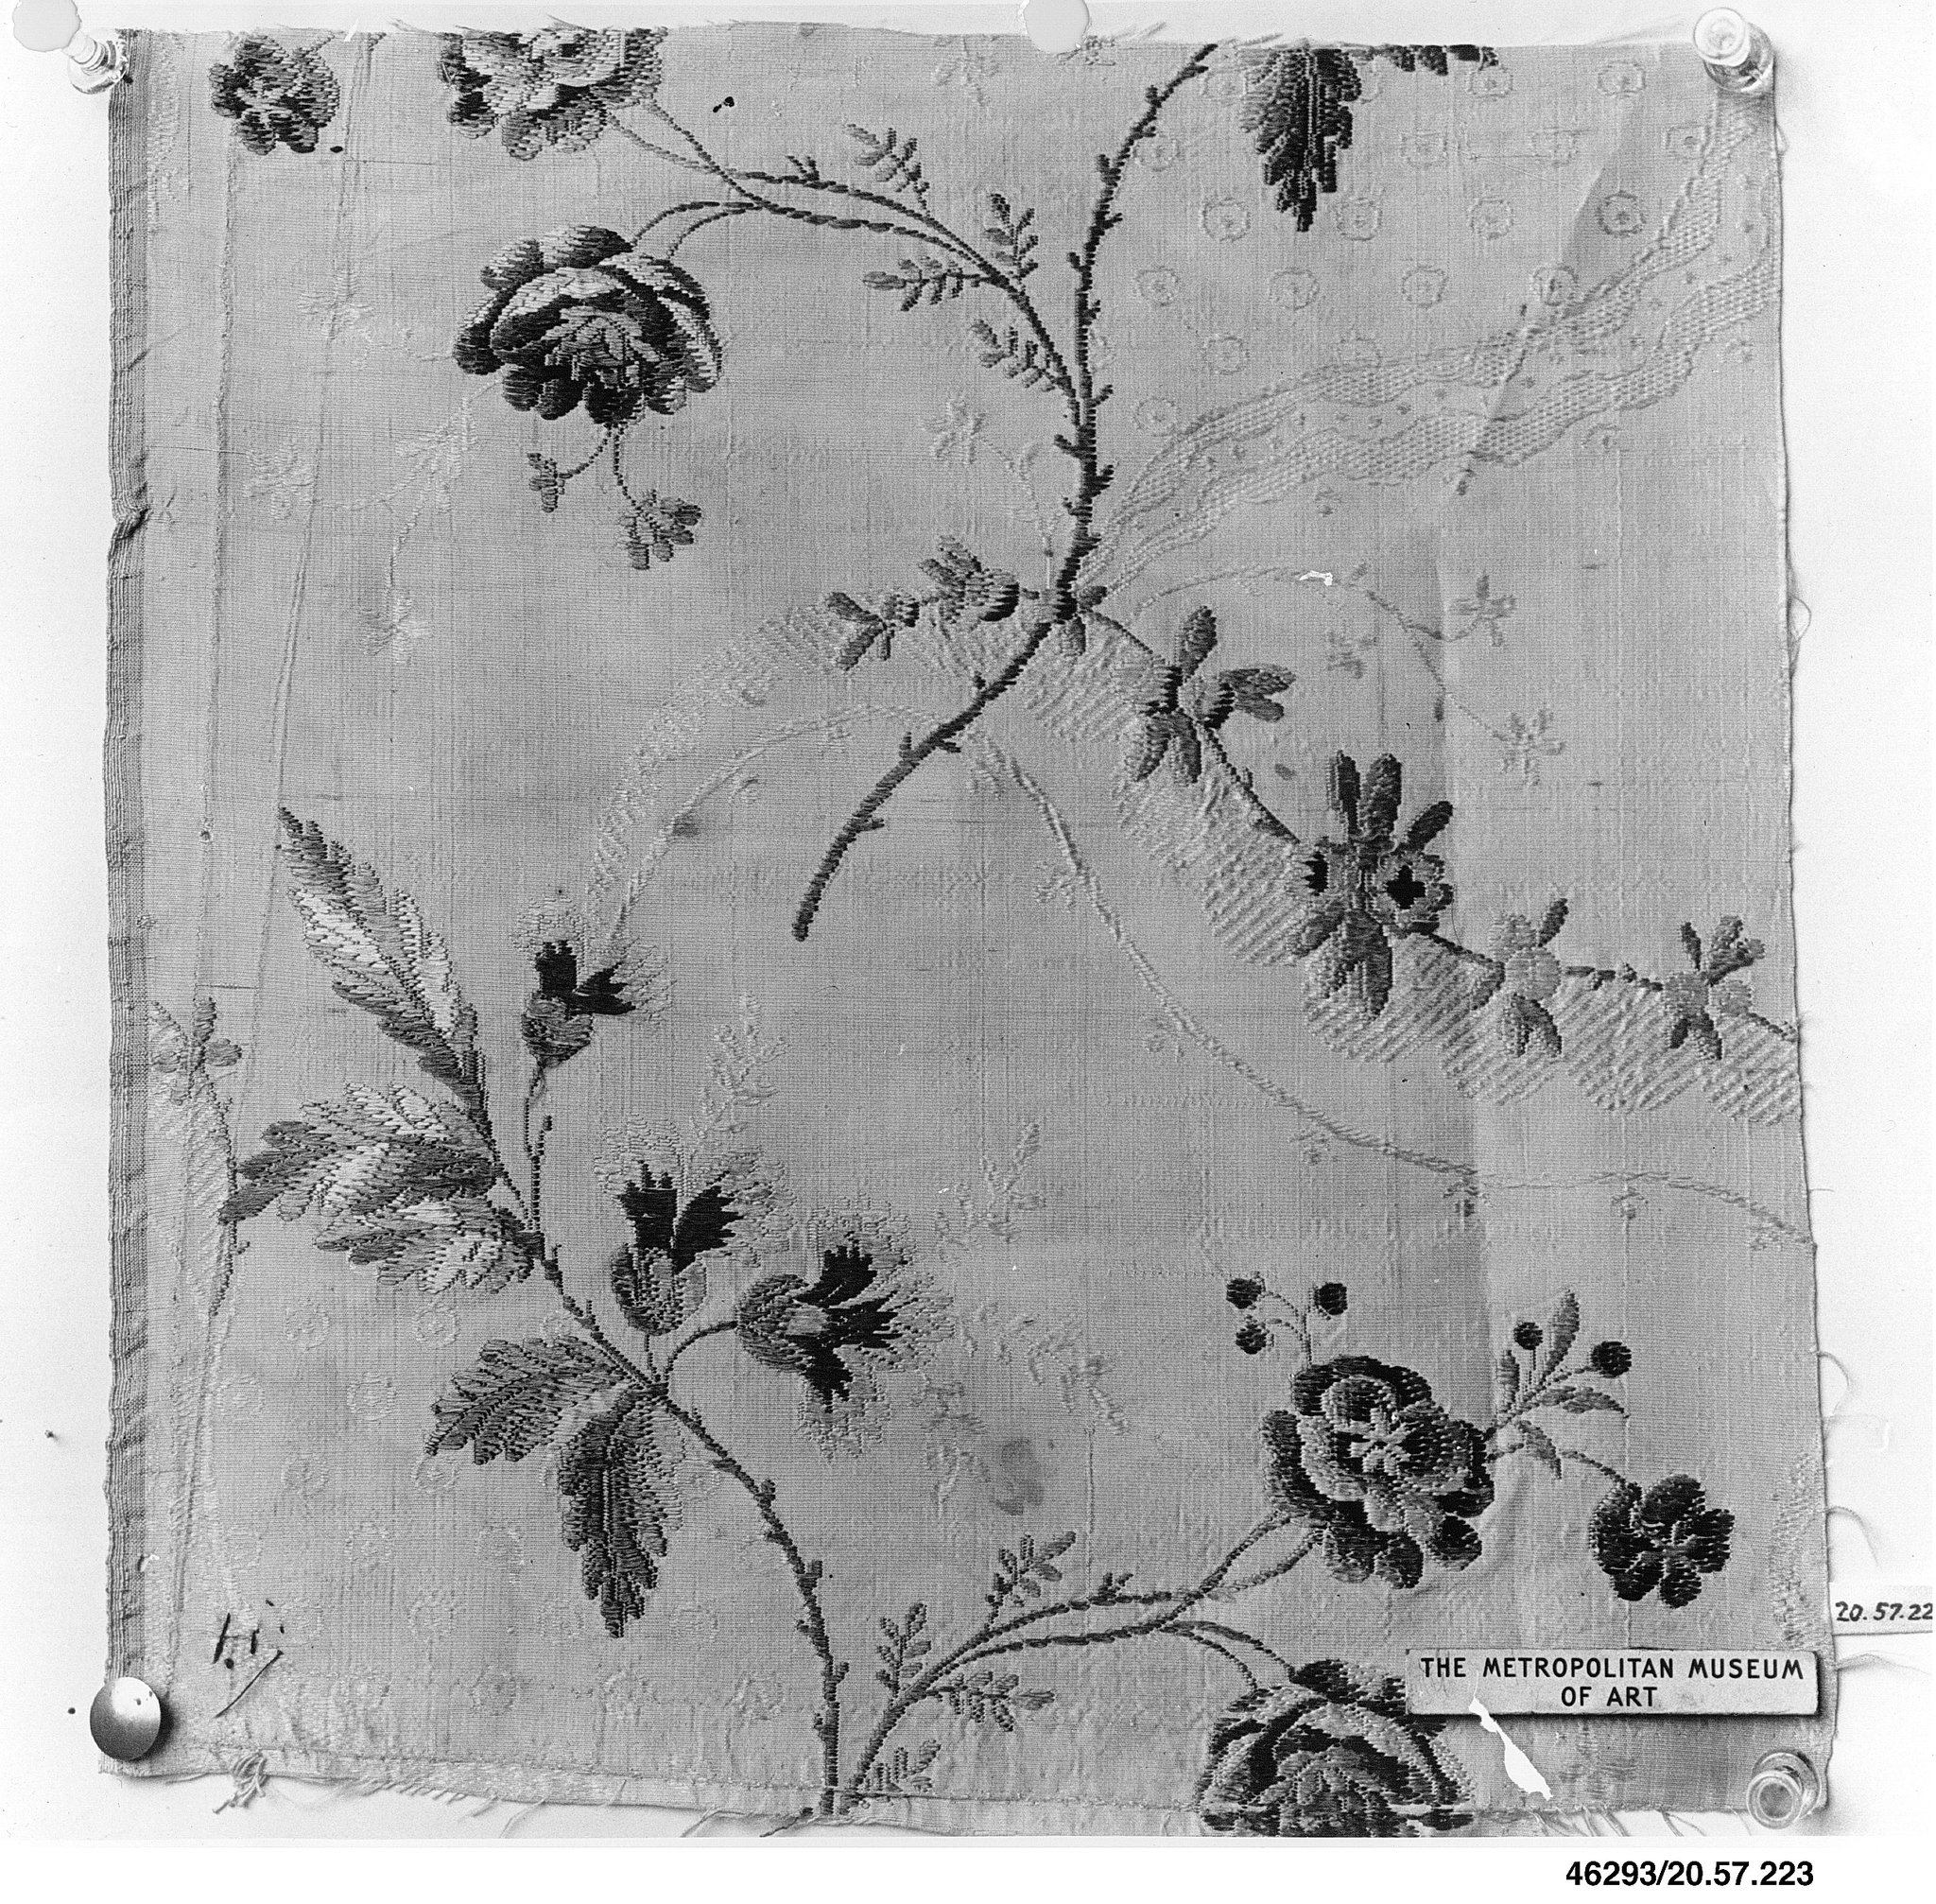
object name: piece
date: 1760-1770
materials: silk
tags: flowers,leaves